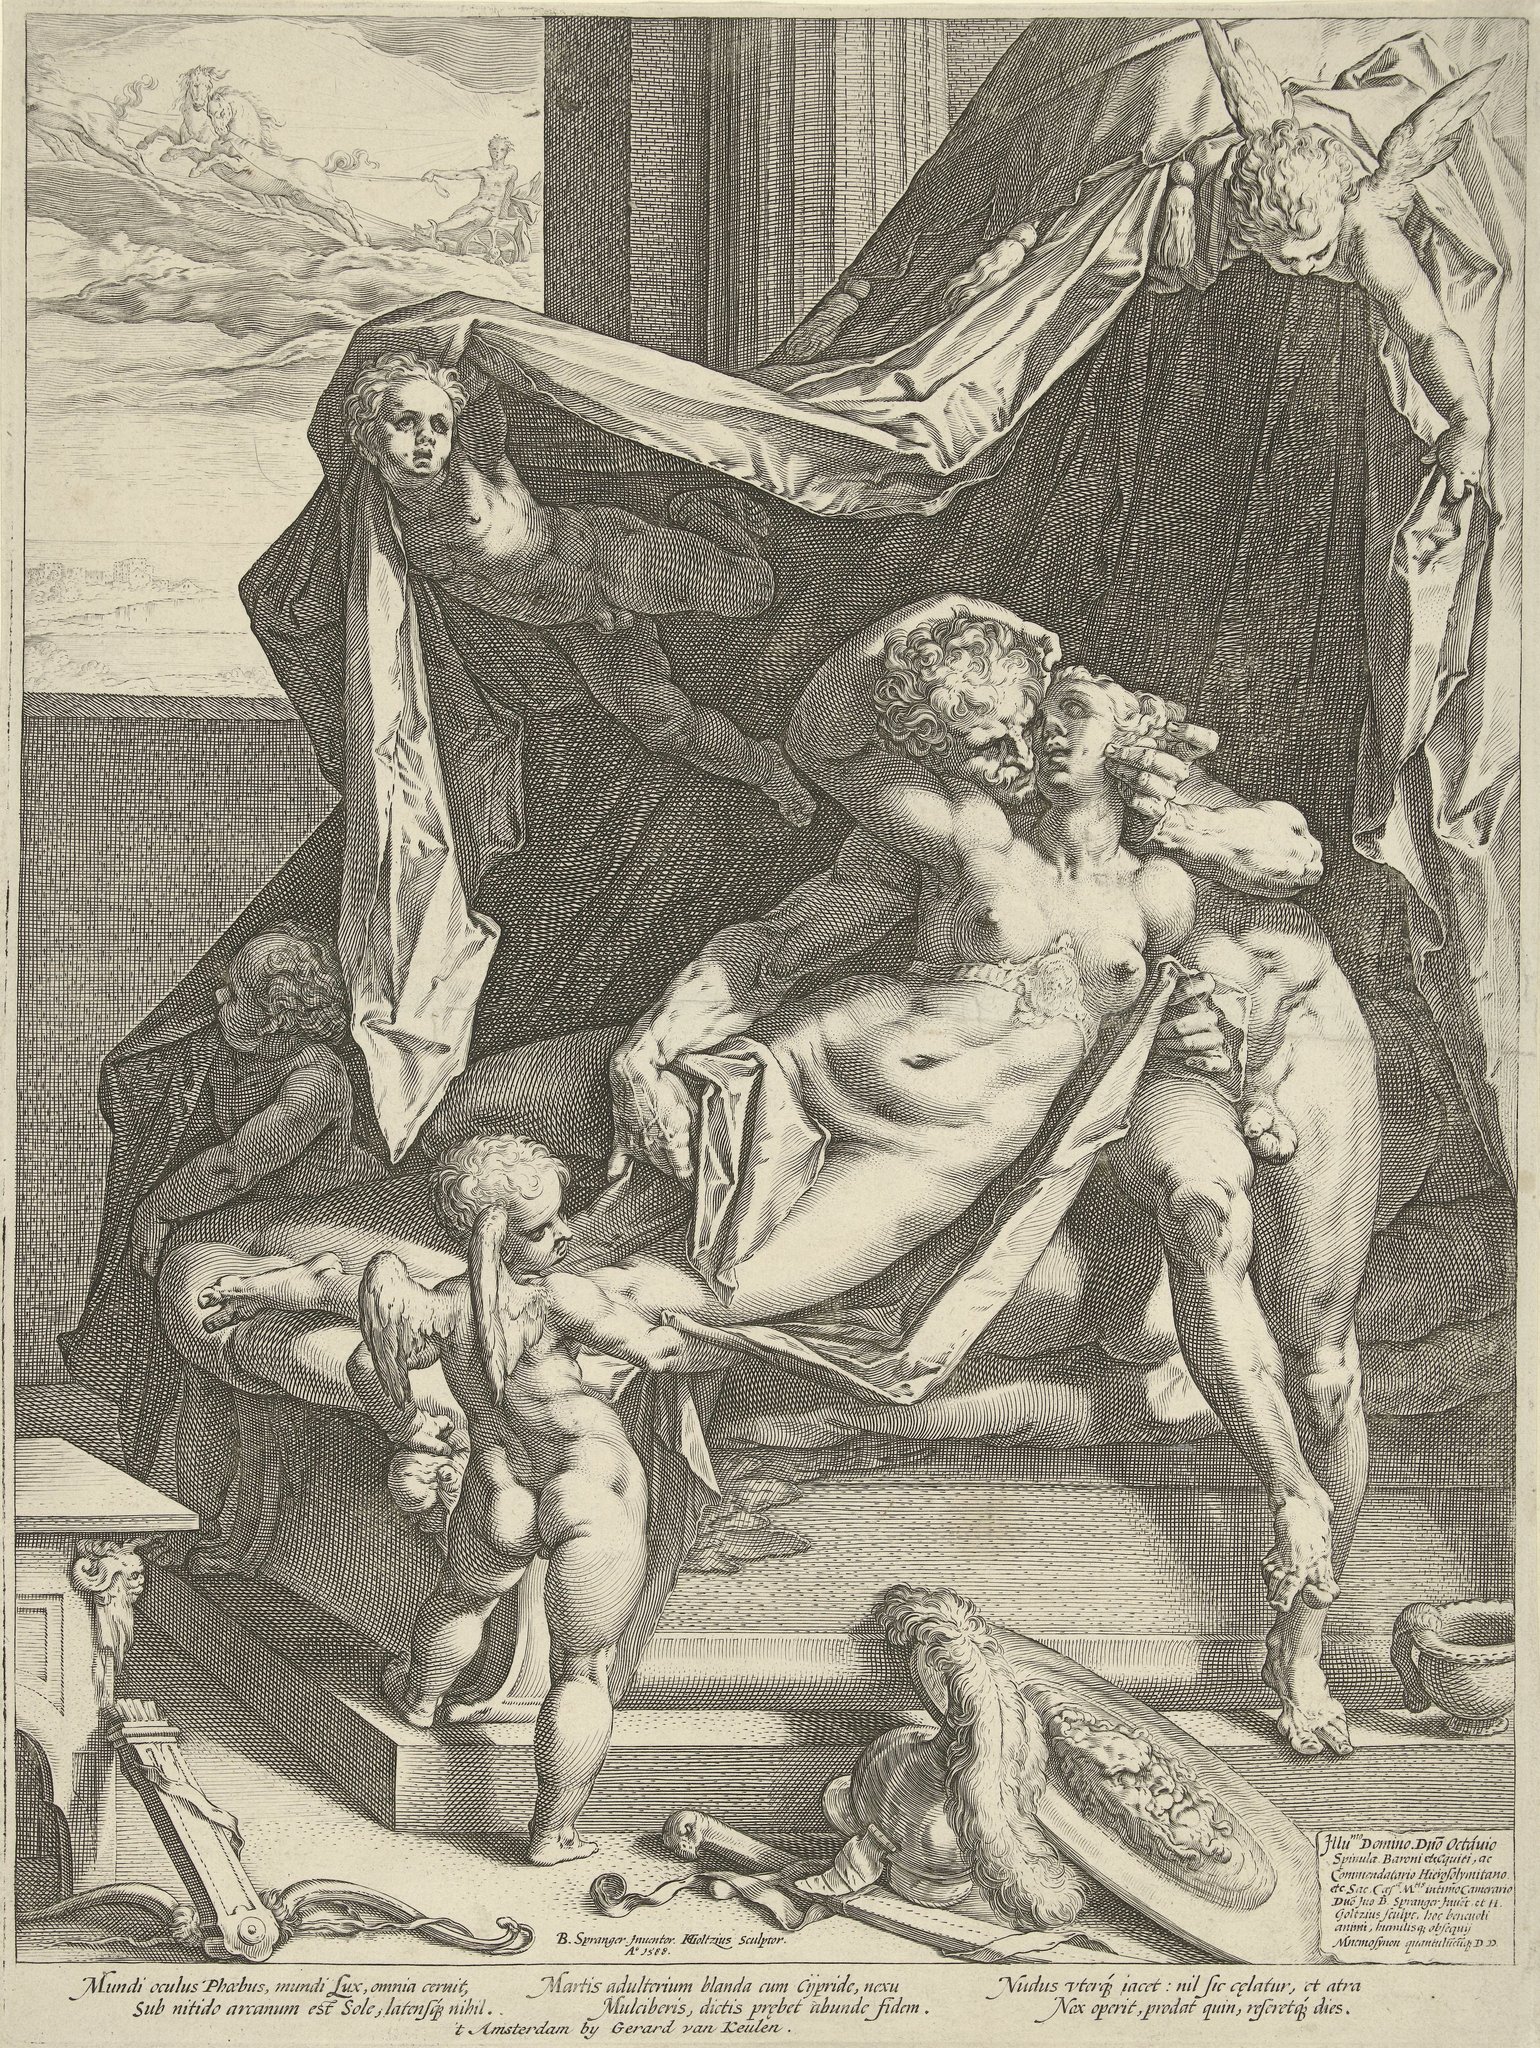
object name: print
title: Mars en Venus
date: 1588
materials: paper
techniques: engraving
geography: amsterdam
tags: mars and venus as lovers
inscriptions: collector's mark: Lugt 2228a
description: Mars en Venus liggen samen in bed, engeltjes staan en vliegen om hen heen, Cupido staat bij het voeteneind. Door het raam is te zien dat Apollo eraan komt op zijn zonnewagen. onder de voorstelling drie maal twee Latijnse versregels.